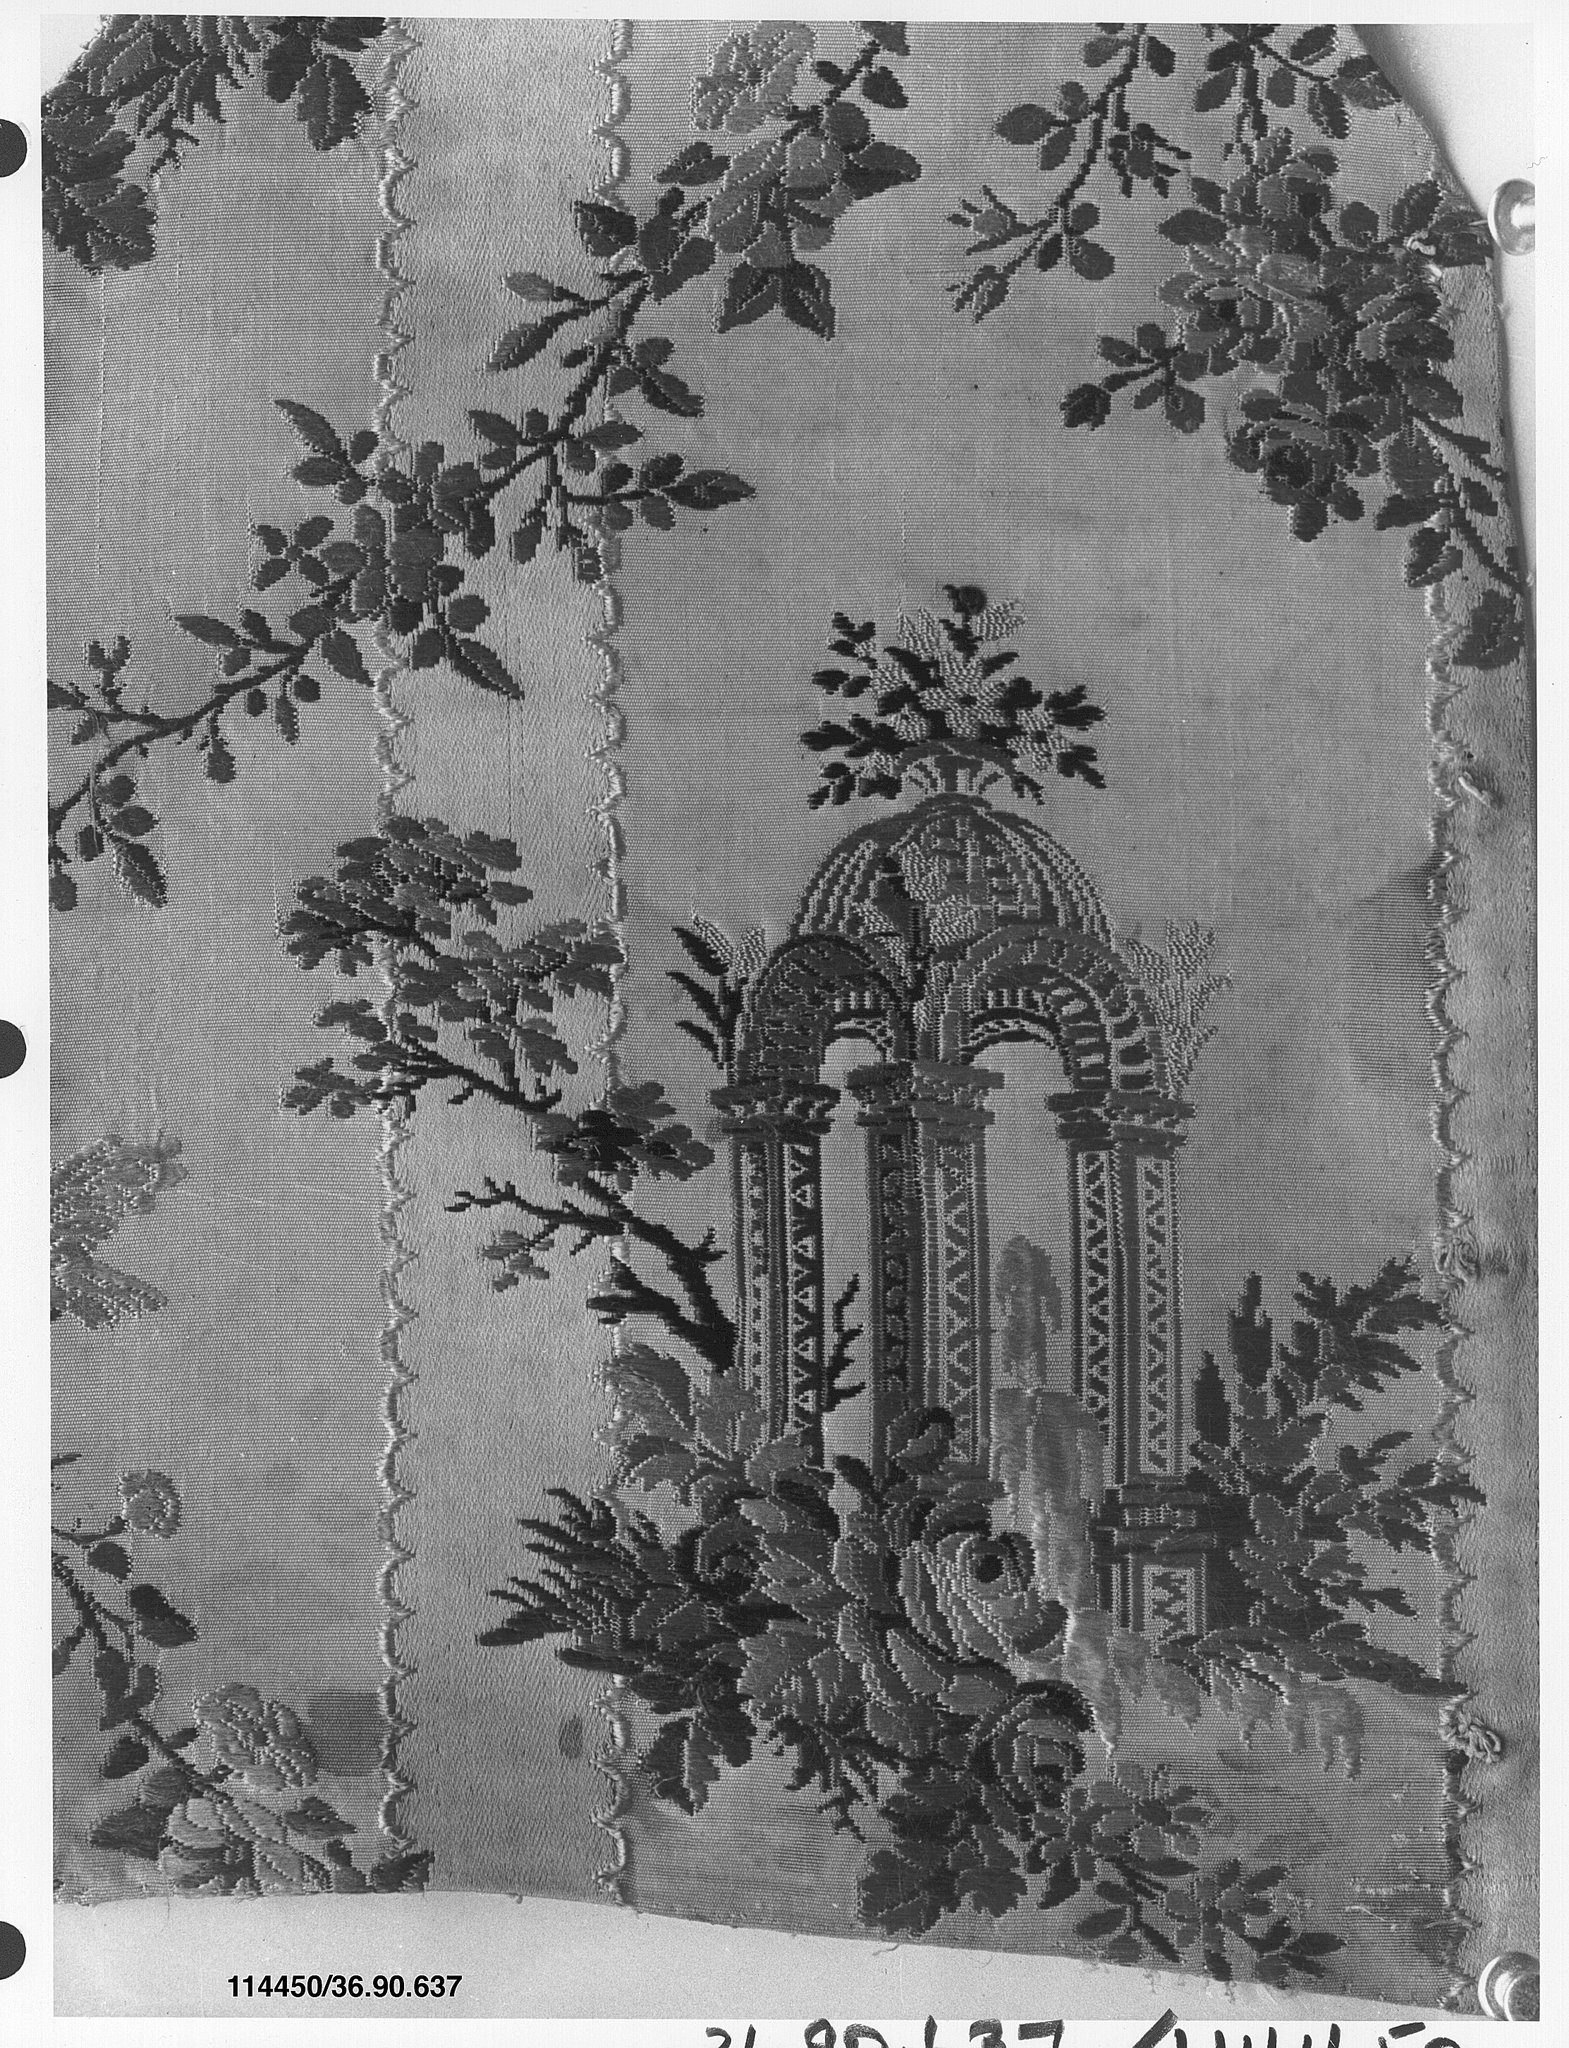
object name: piece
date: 1770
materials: silk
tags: buildings,flowers,leaves